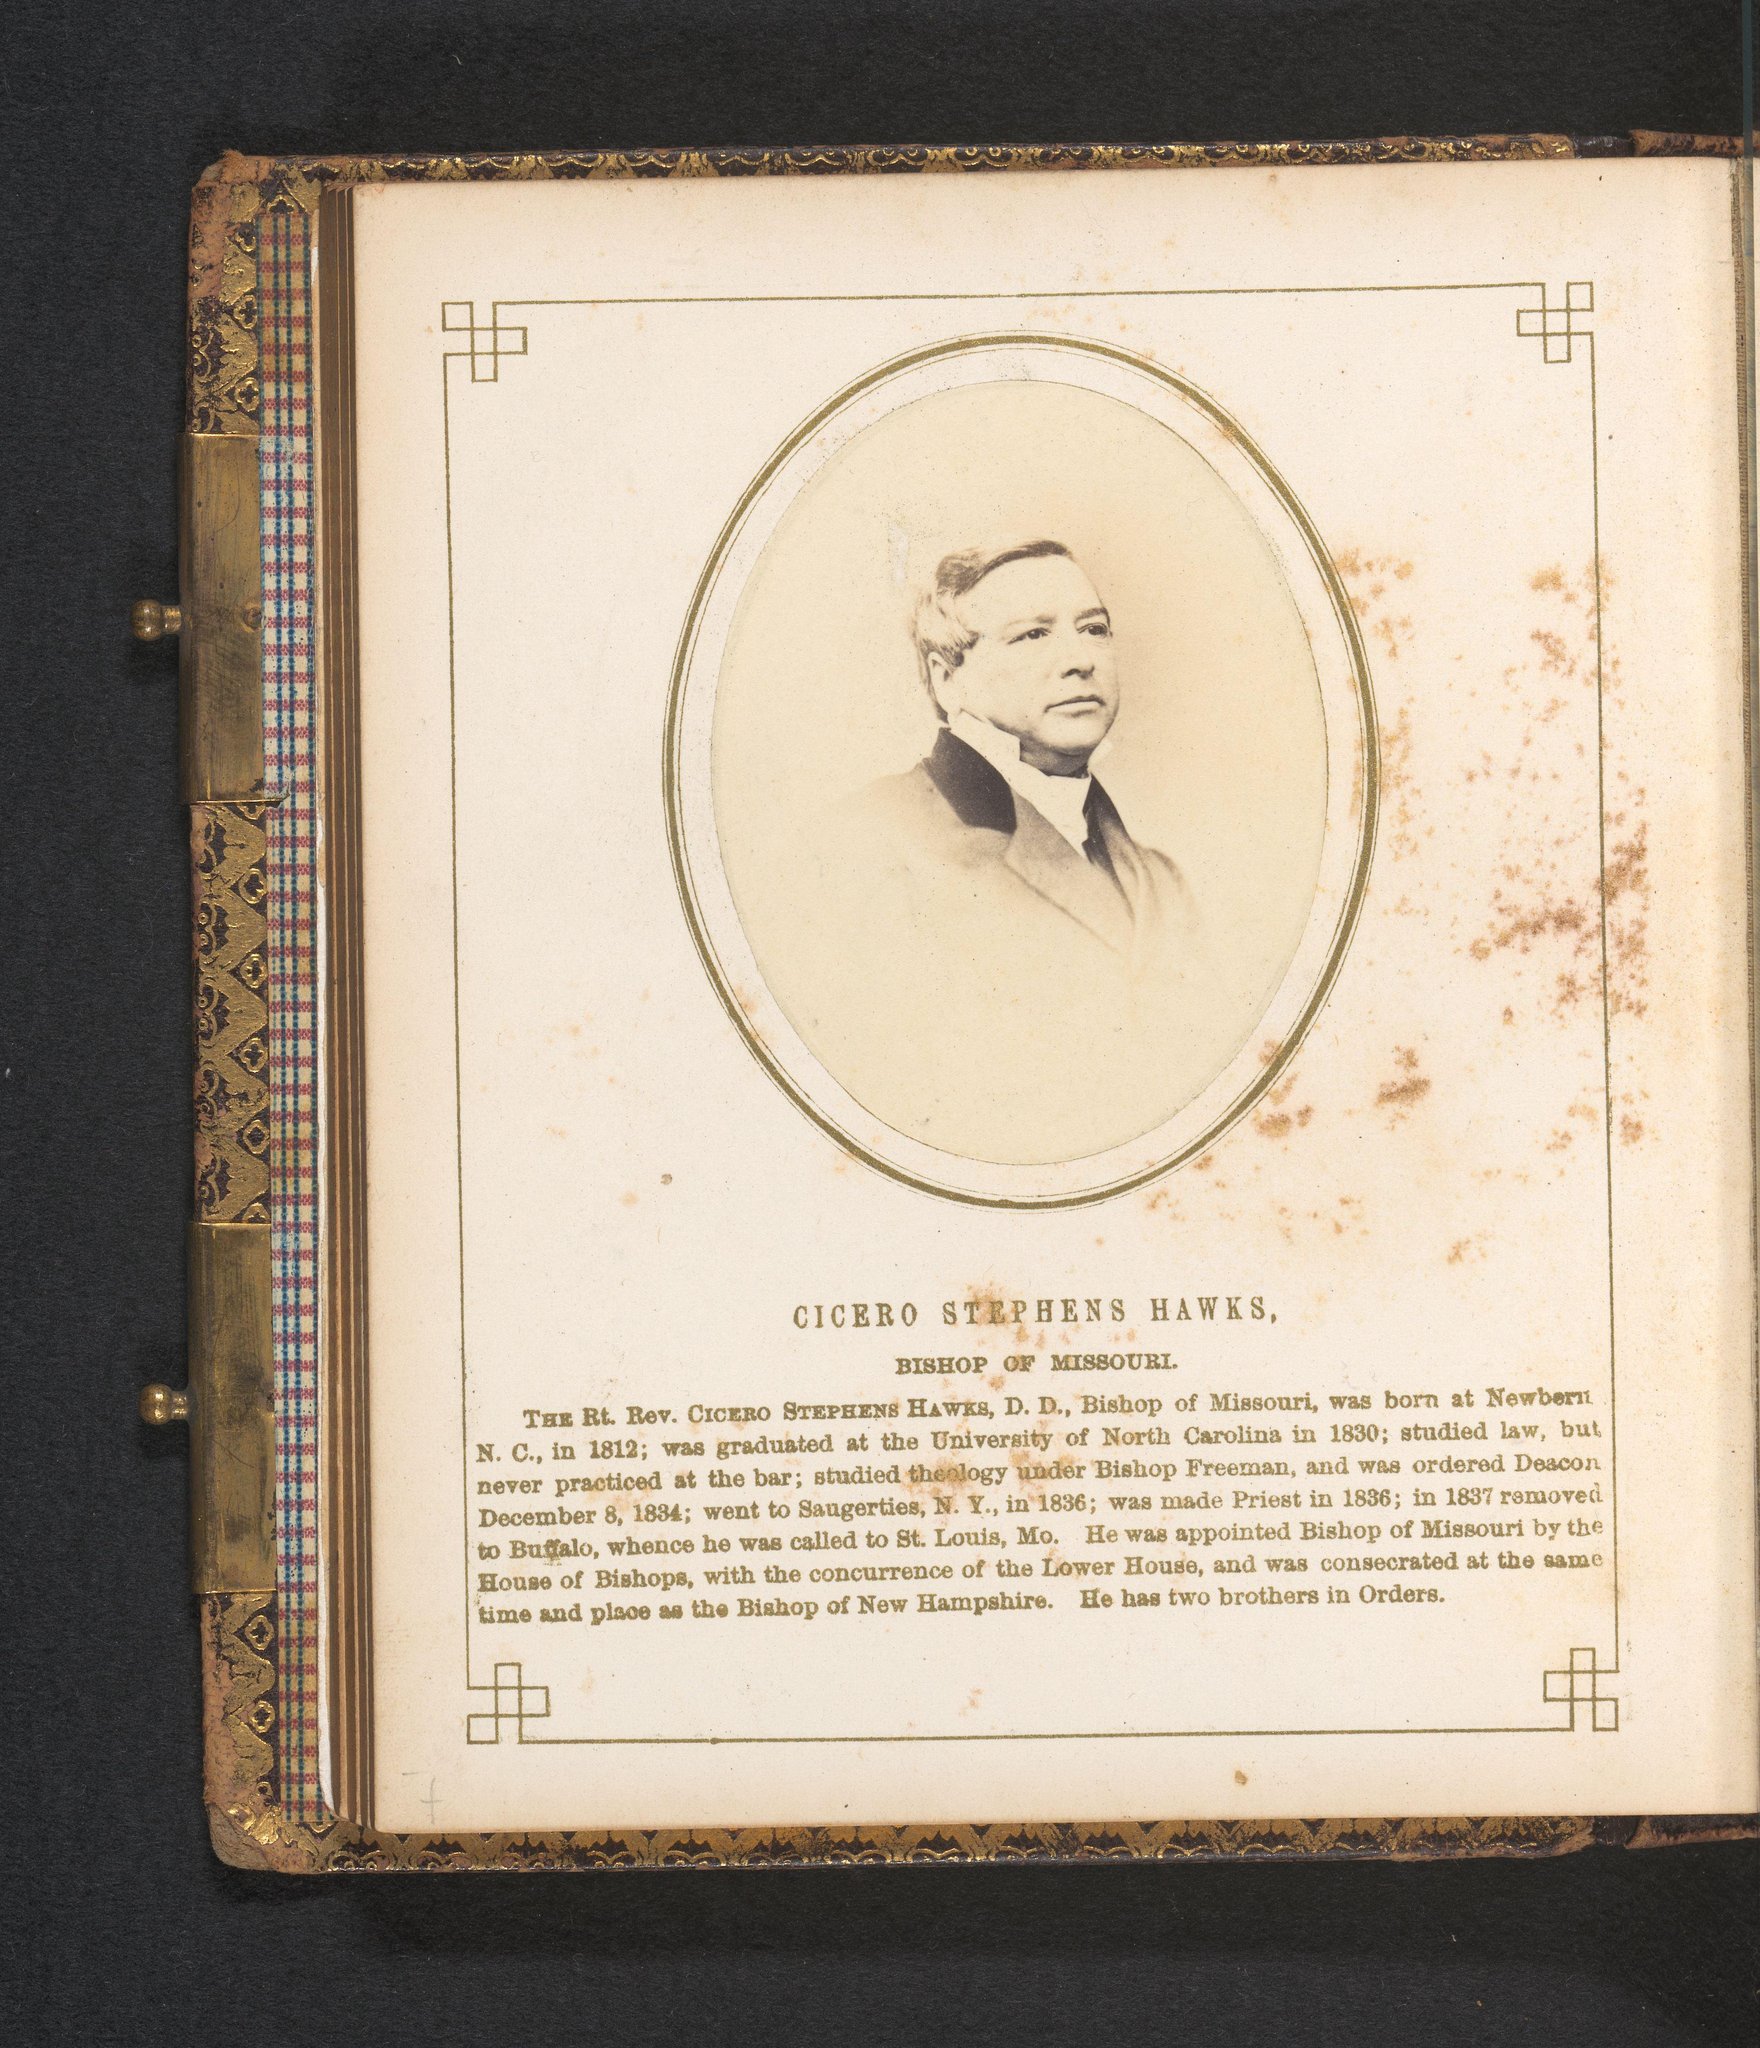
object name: photograph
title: Portret van Cicero Stephens Hawks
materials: photographic support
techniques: albumen print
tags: historical persons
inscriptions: inscription: ‘Cicero Stephens Hawks/ Bishop of Misouri (...)’